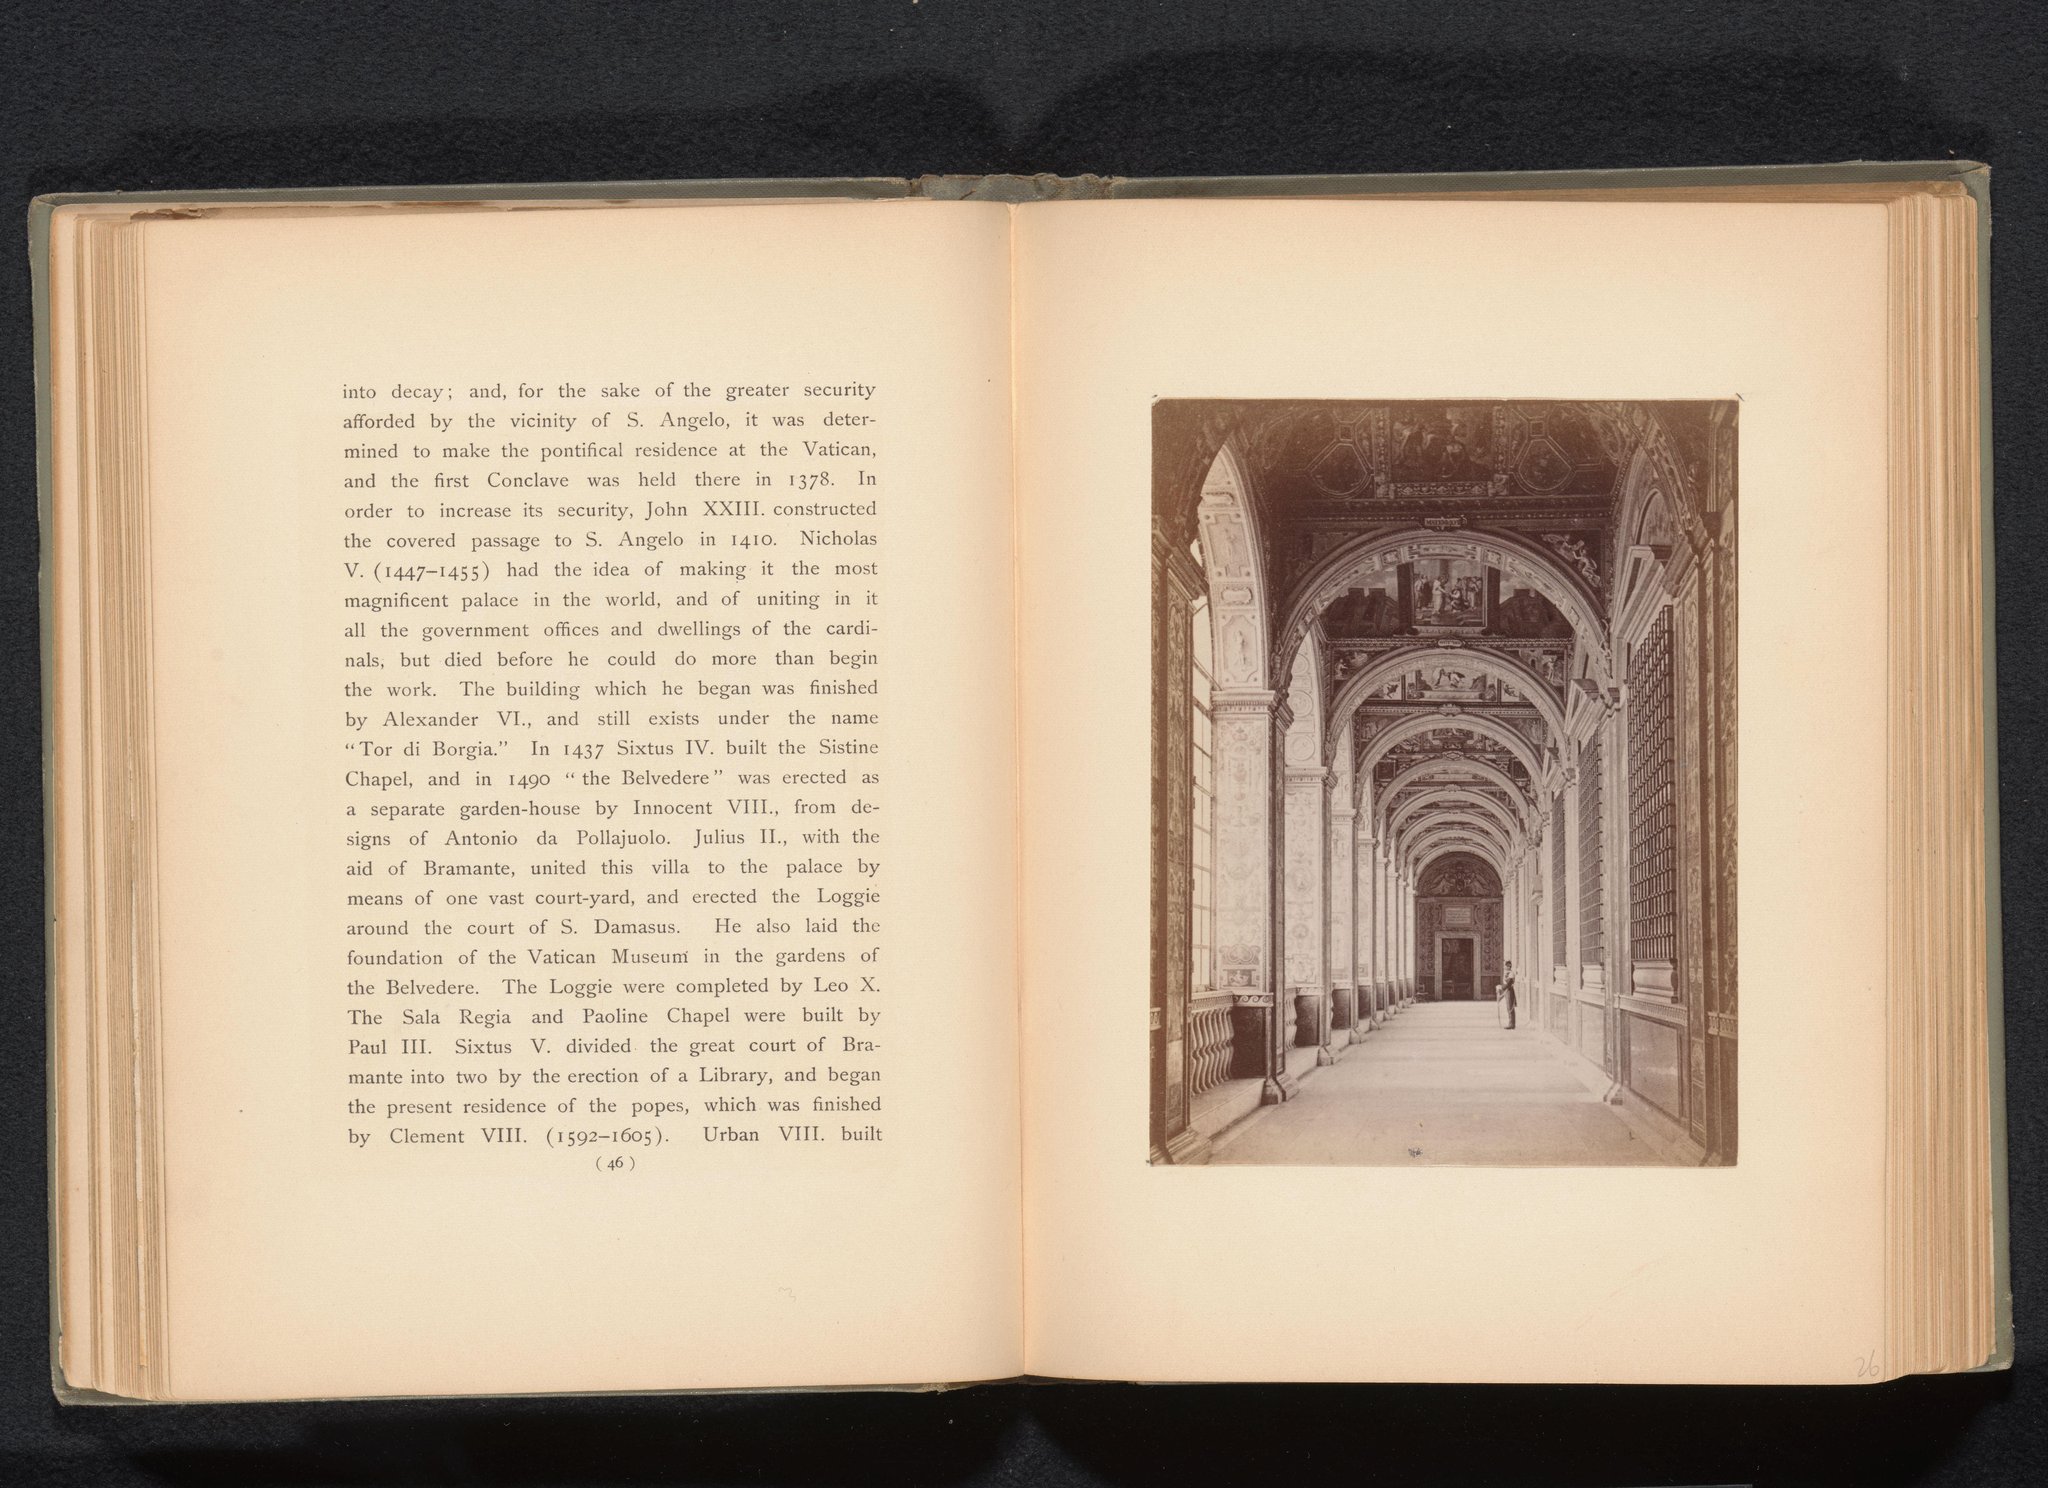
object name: page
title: Galerij in het Apostolisch Paleis te Vaticaanstad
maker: Anonymous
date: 1882-1887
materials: photographic support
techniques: albumen print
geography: apostolisch paleis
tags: gallery (spacious corridor)